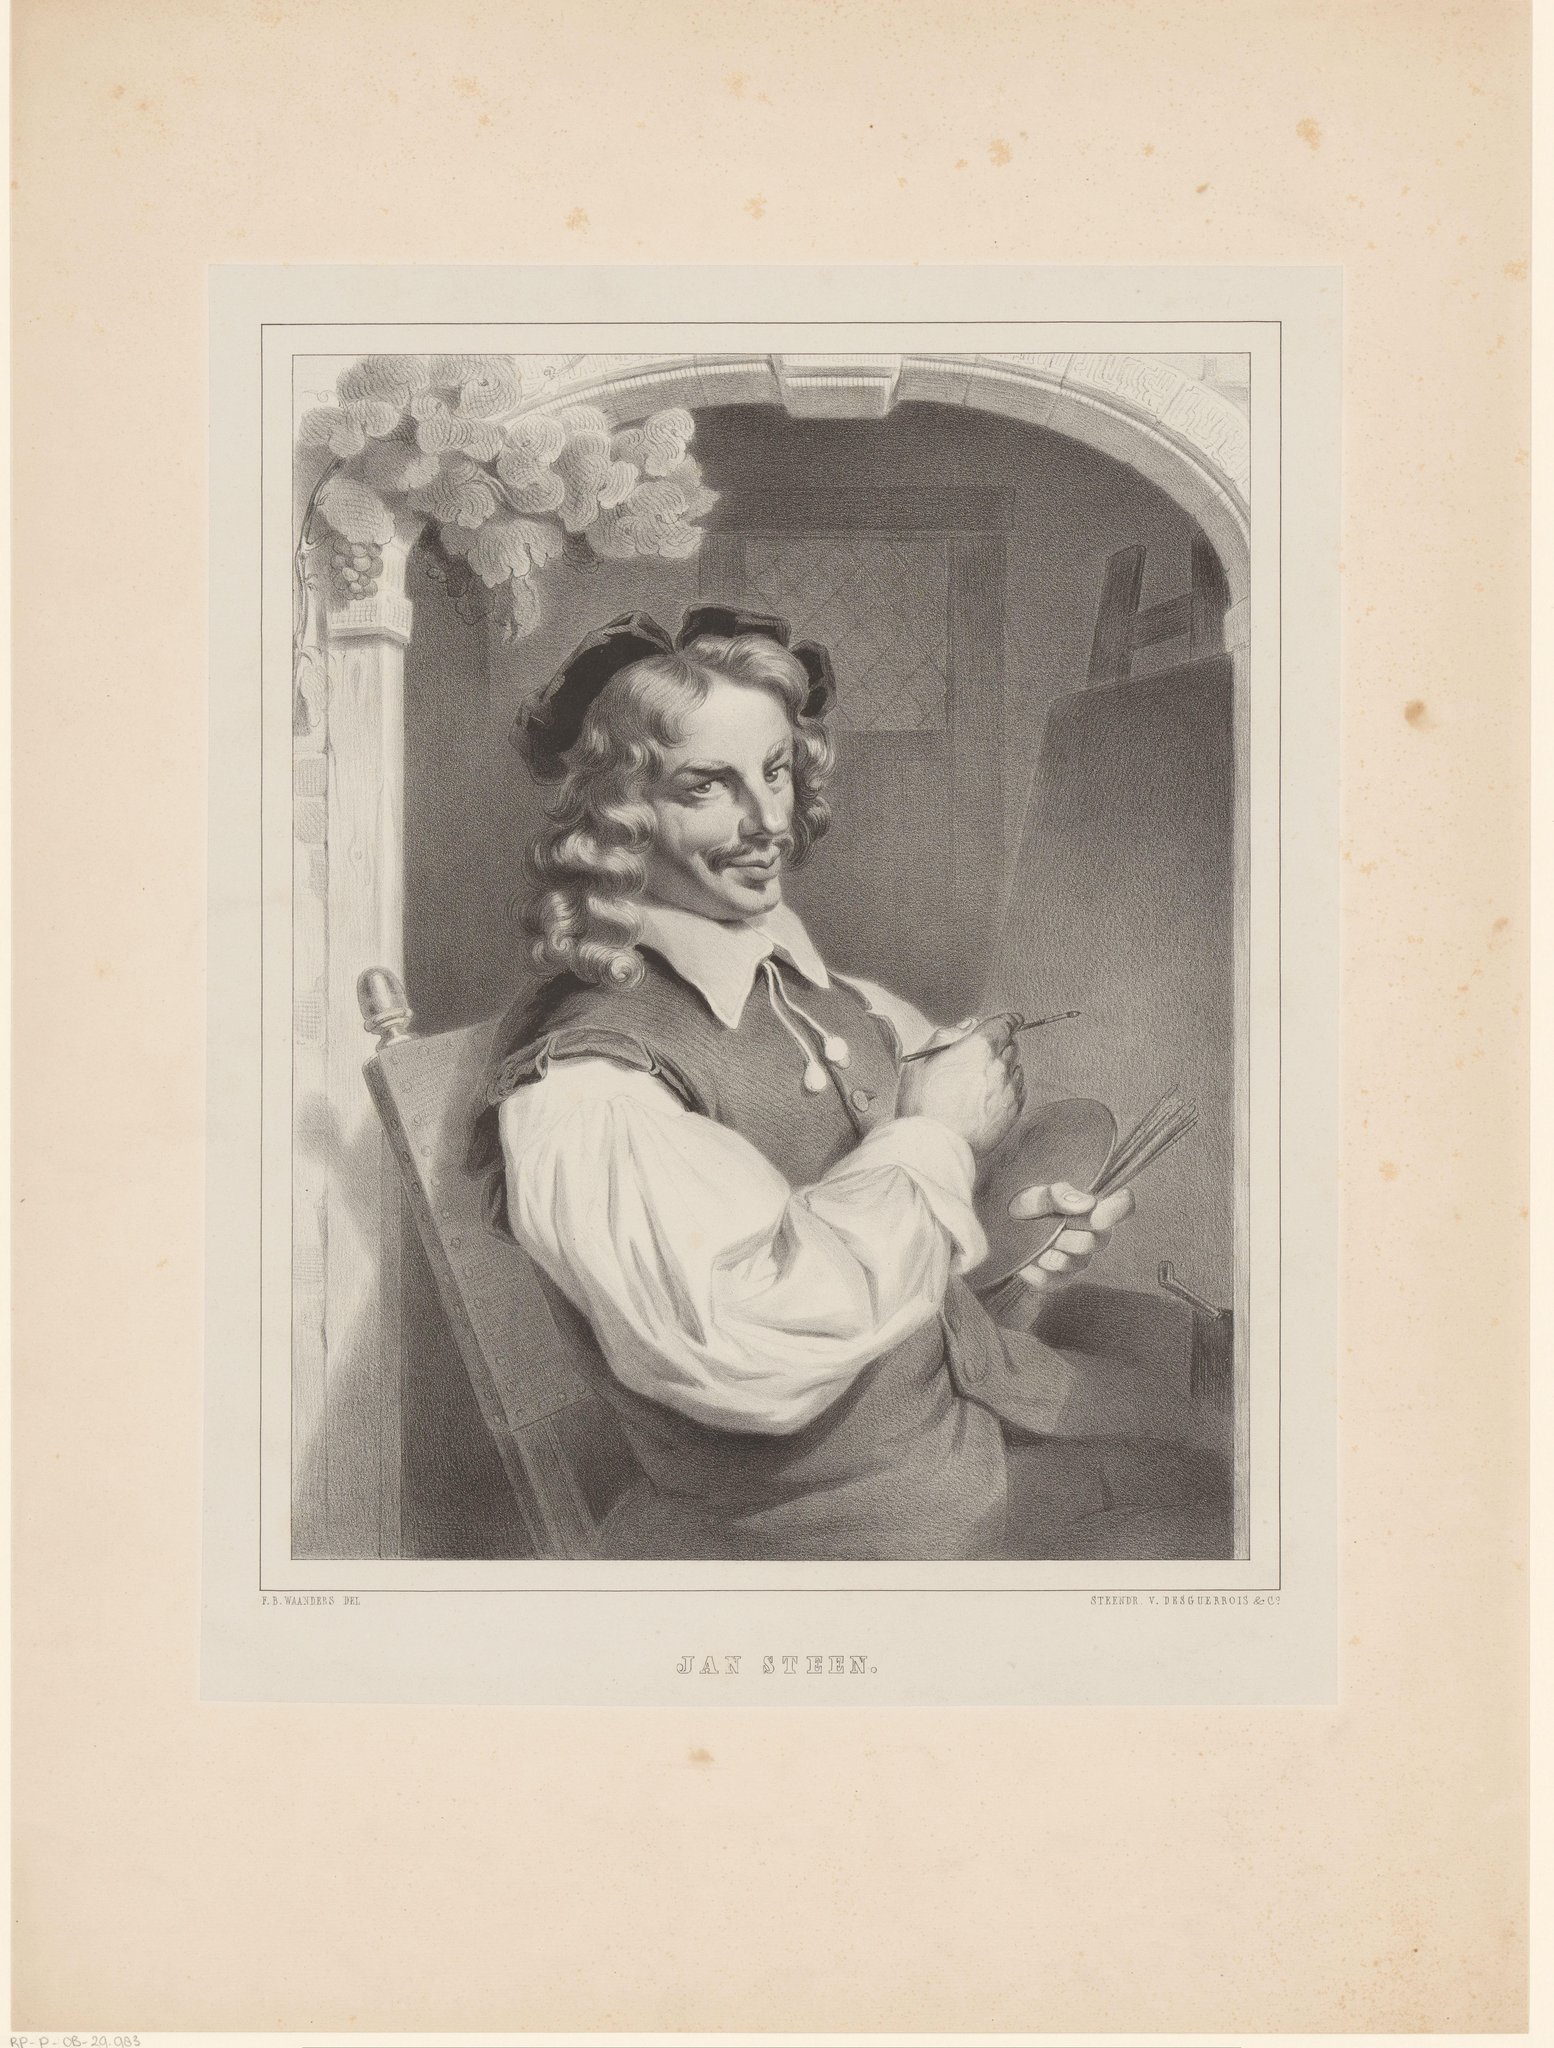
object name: print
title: Portret van Jan Steen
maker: franciscus bernardus waanders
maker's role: print maker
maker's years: 1809-1880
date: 1827-1880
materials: paper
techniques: lithograph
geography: amsterdam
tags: painter, jan havicksz. steen, historical persons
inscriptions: collector's mark: Lugt 2228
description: De kunstenaar zittend met schilderspalet en kwasten in zijn handen.